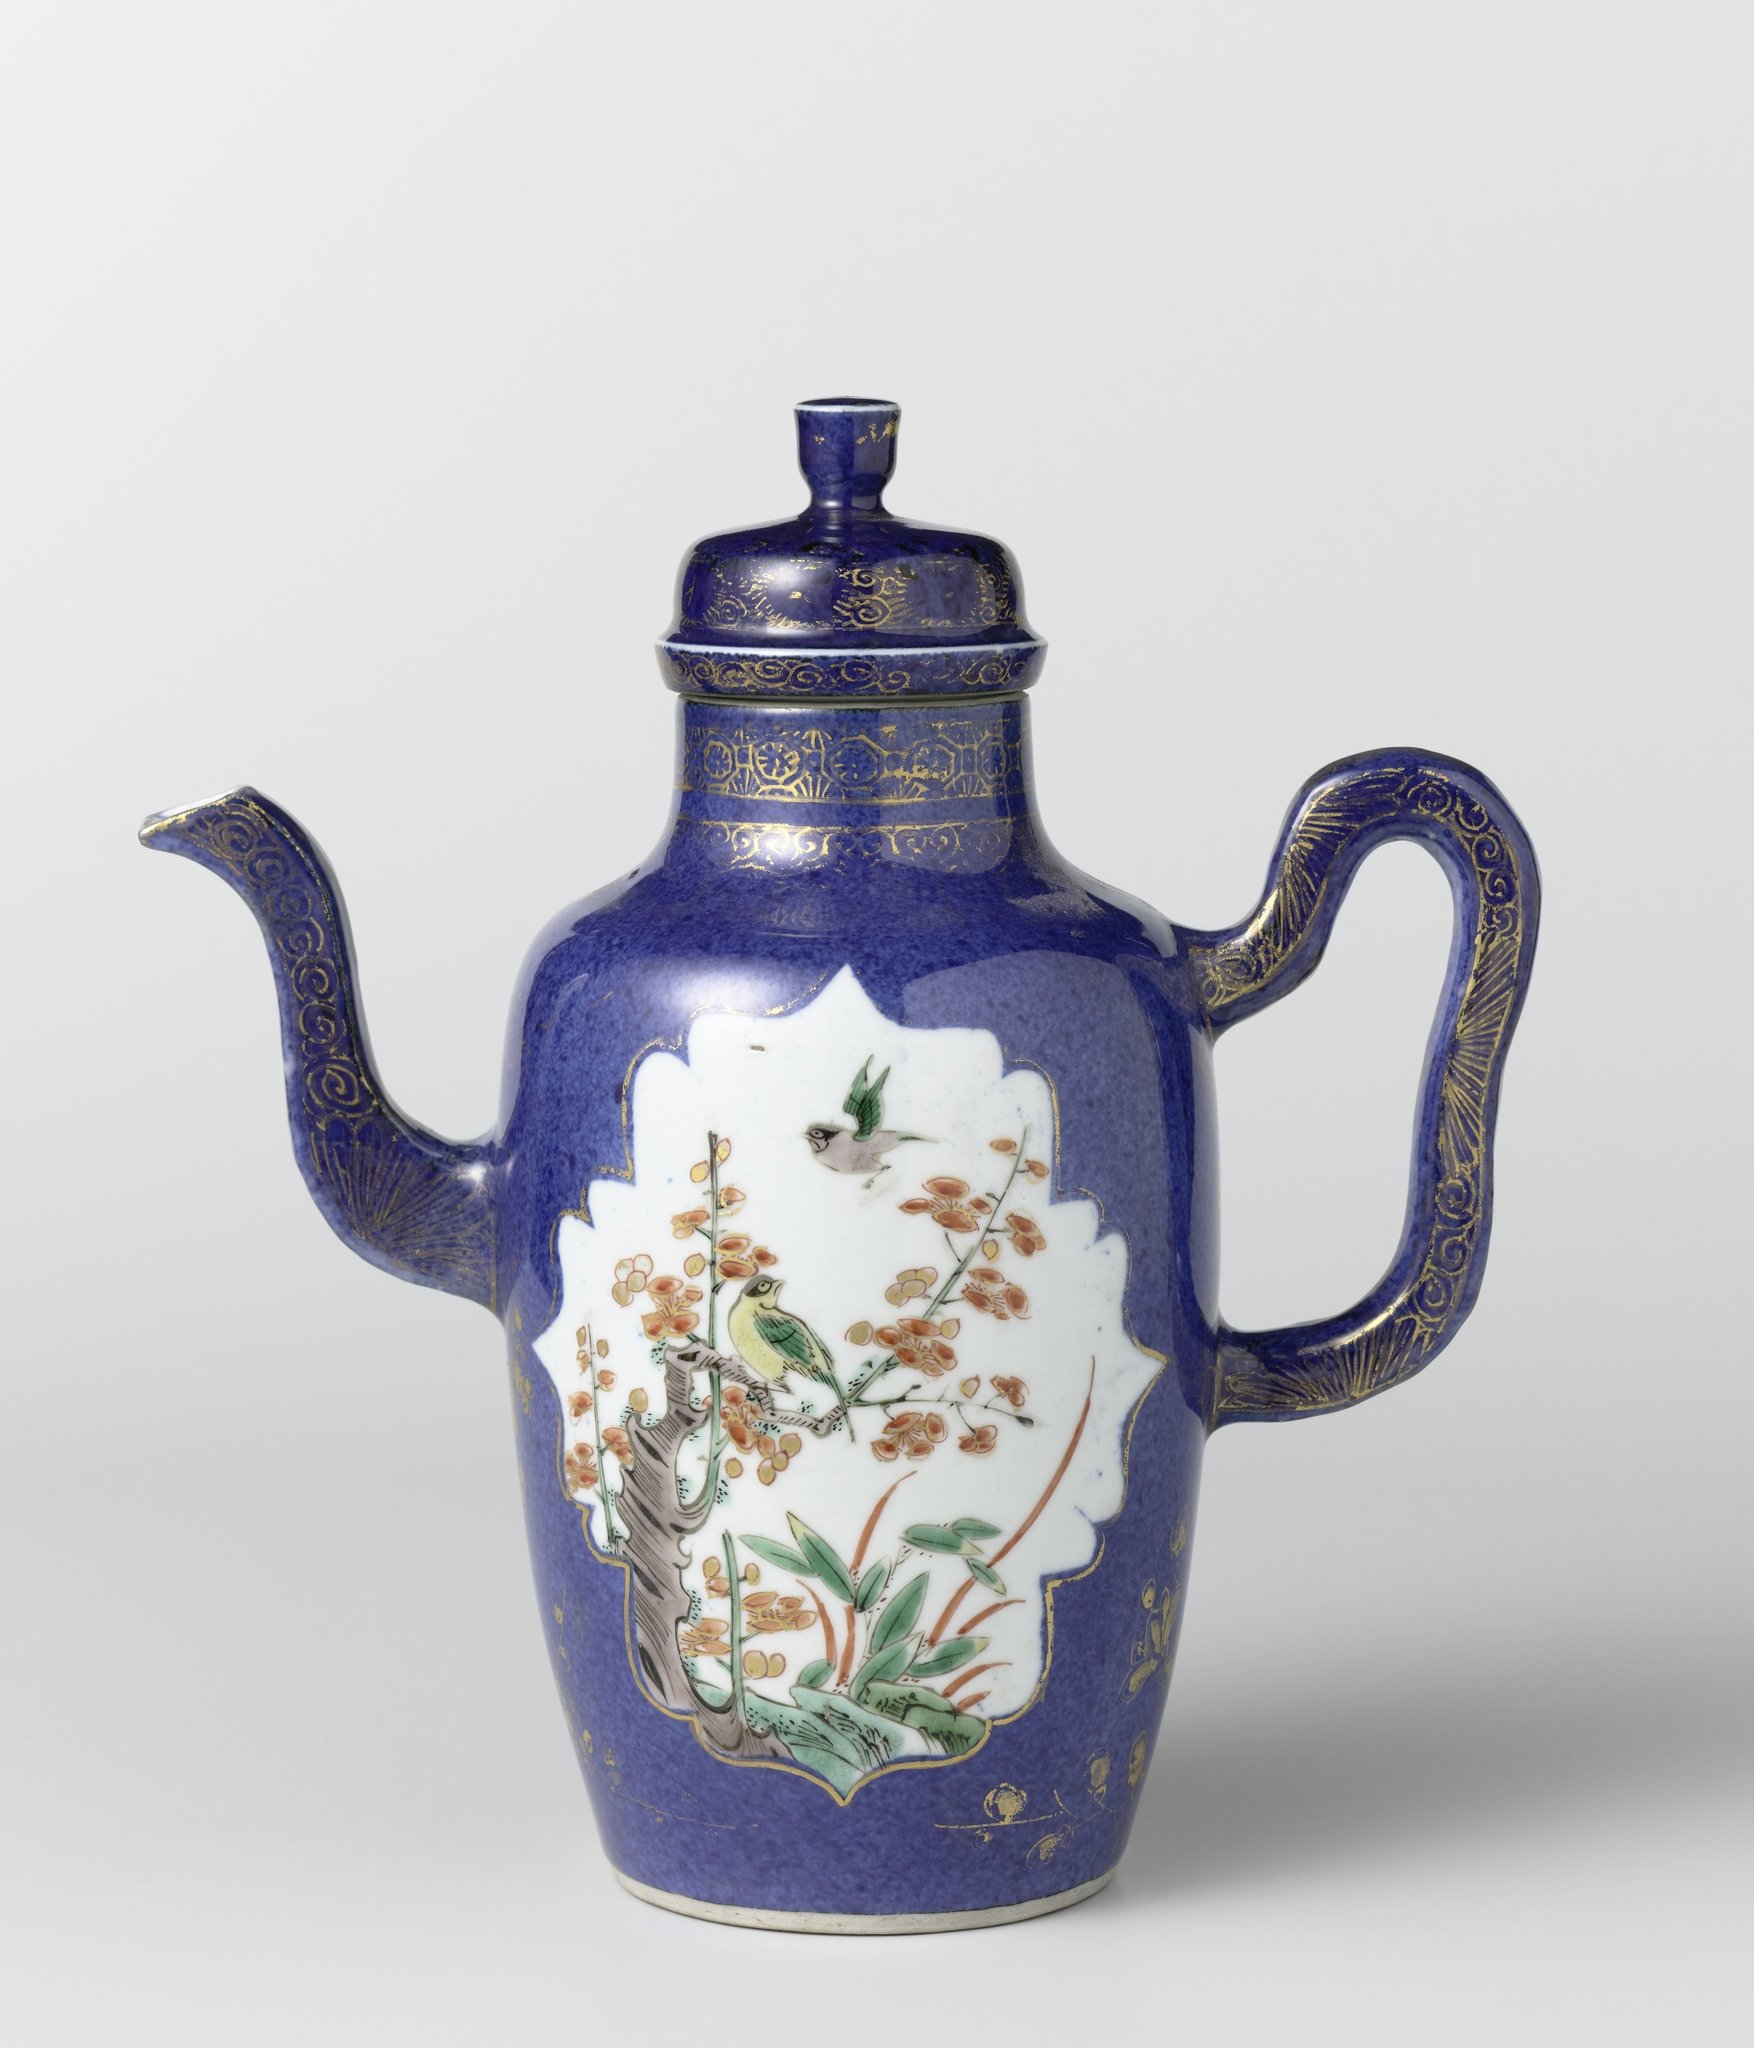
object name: flagon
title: Covered ewer with powder blue and panels in reserve with flower sprays and birds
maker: Anonymous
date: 1700-1724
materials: cobalt, glaze, gold, paint, porcelain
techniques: firing, gilding, turning, vitrification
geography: china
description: Deksel van schenkkan van porselein, beschilderd in onderglazuur blauw en op het glazuur rood, groen, geel, aubergine, zwart en goud. Bedekt met bleu poudré (poederblauw) en vier decoratieve banden in goud. Bleu poudré met famille verte.